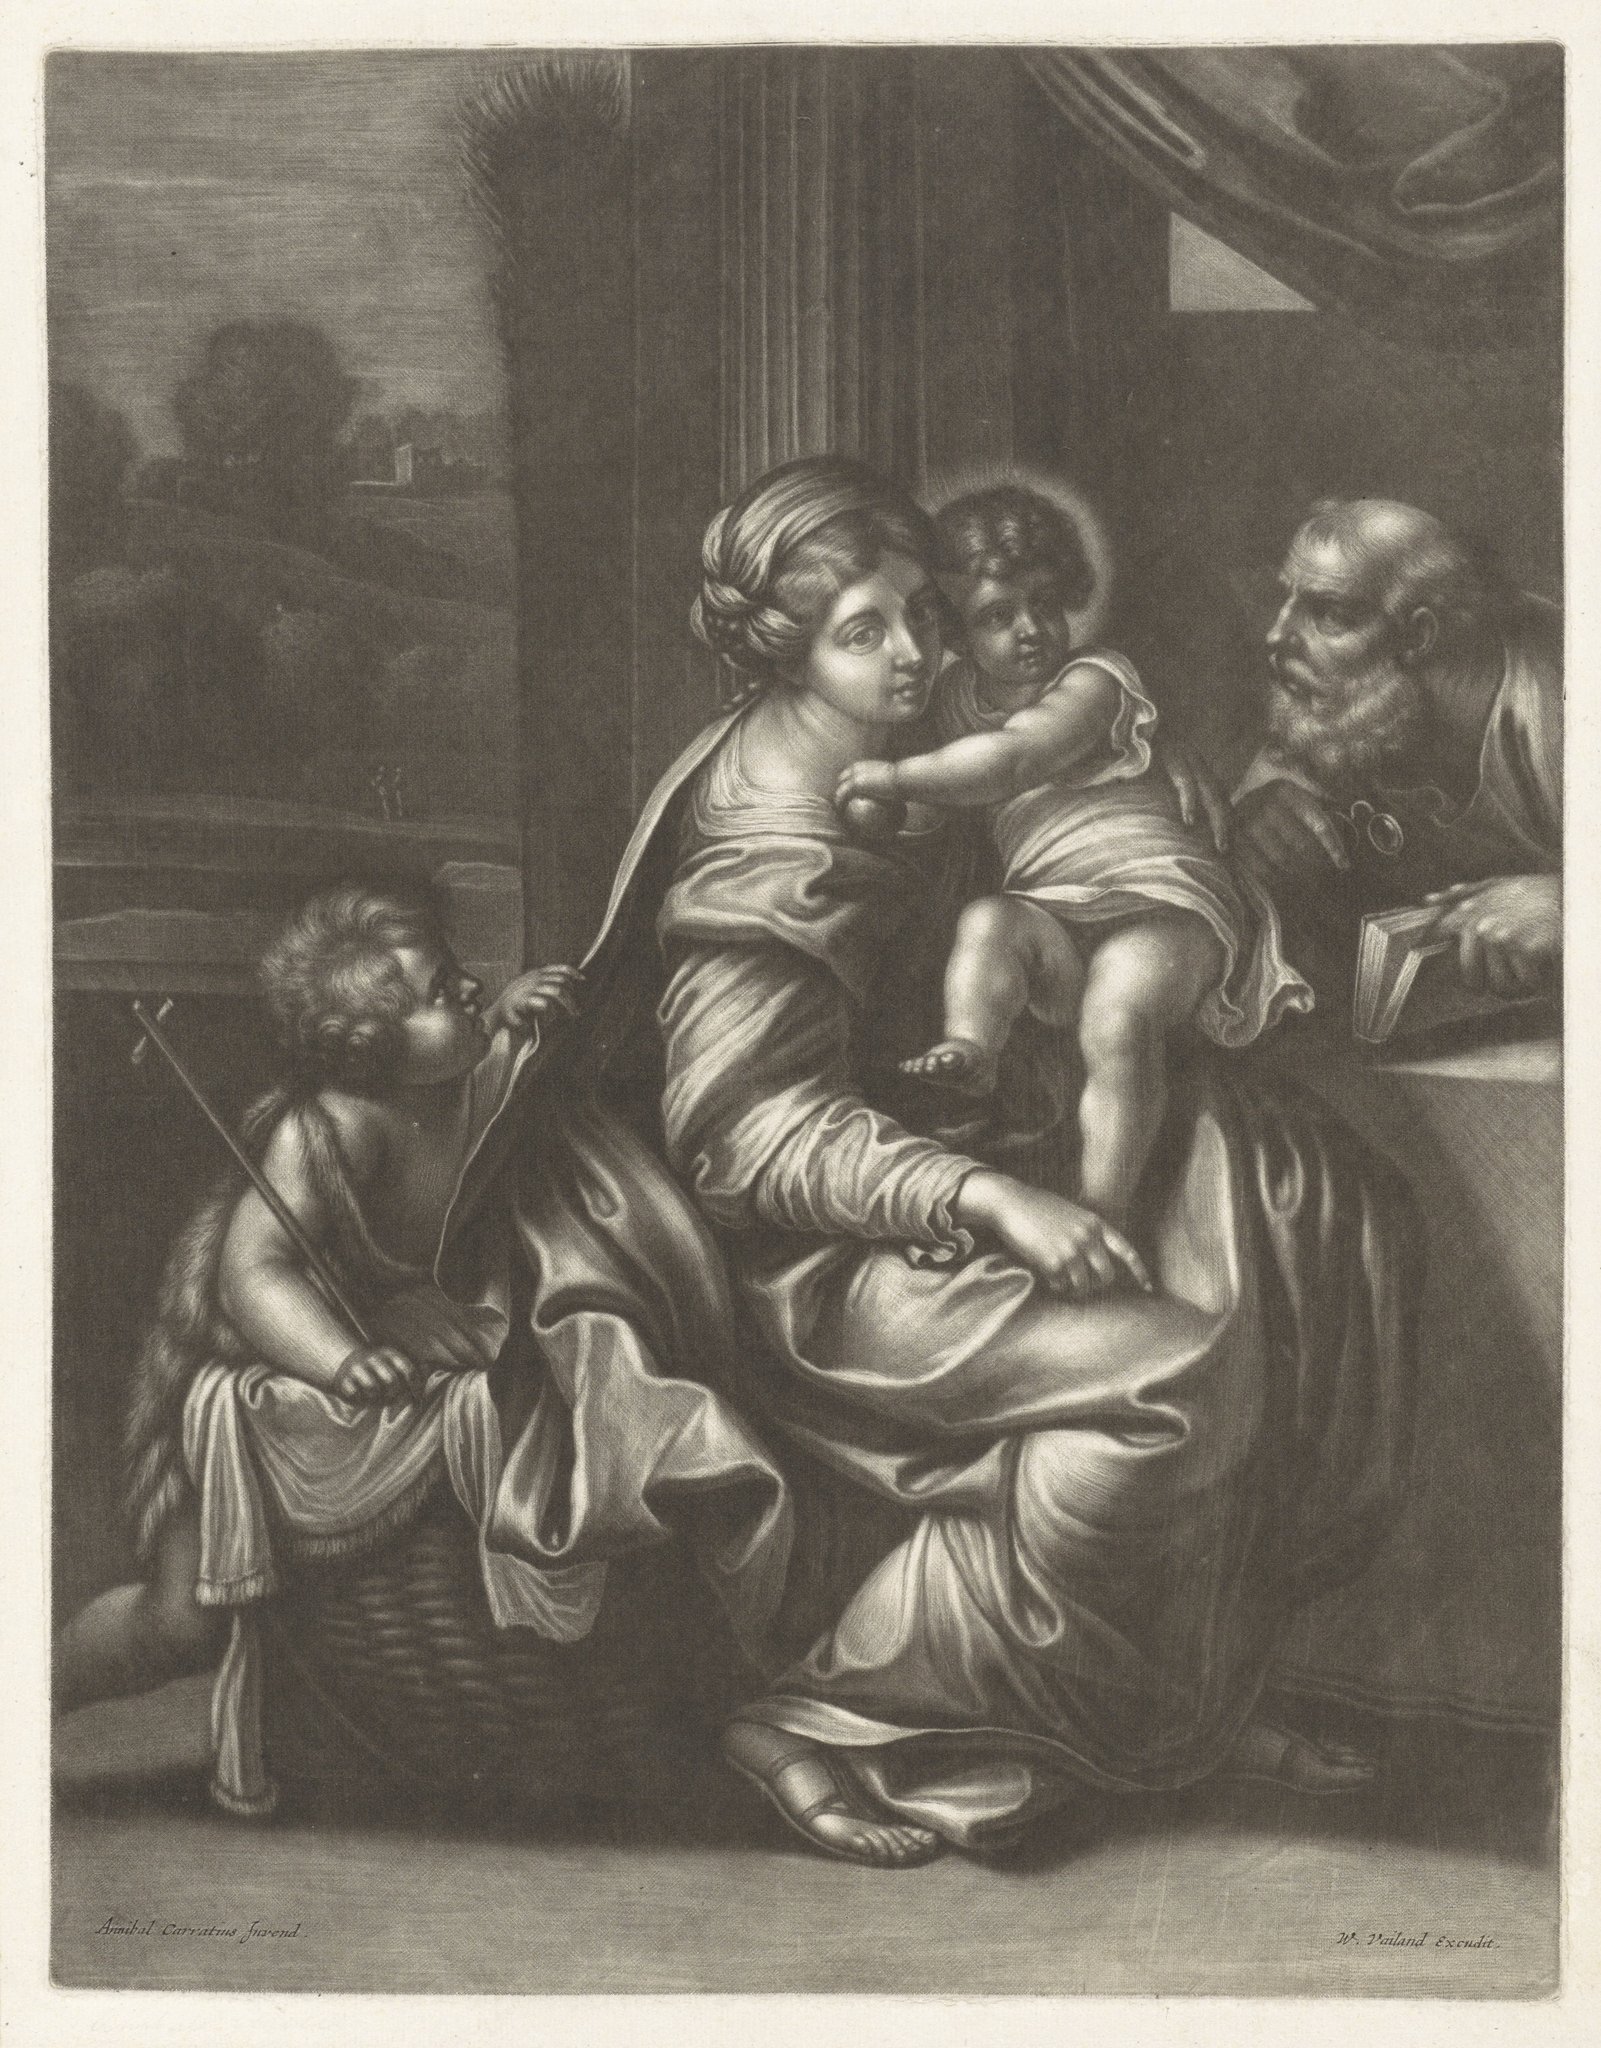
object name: print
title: Heilige Familie met Johannes de Doper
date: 1658-1677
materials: paper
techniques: mezzotint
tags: holy family with john the baptist (as child)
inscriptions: collector's mark: Lugt 10, collector's mark: Lugt 11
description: Maria en Jozef met het Christuskind. Naast Maria staat Johannes de Doper als kind, hij trekt aan haar mantel.